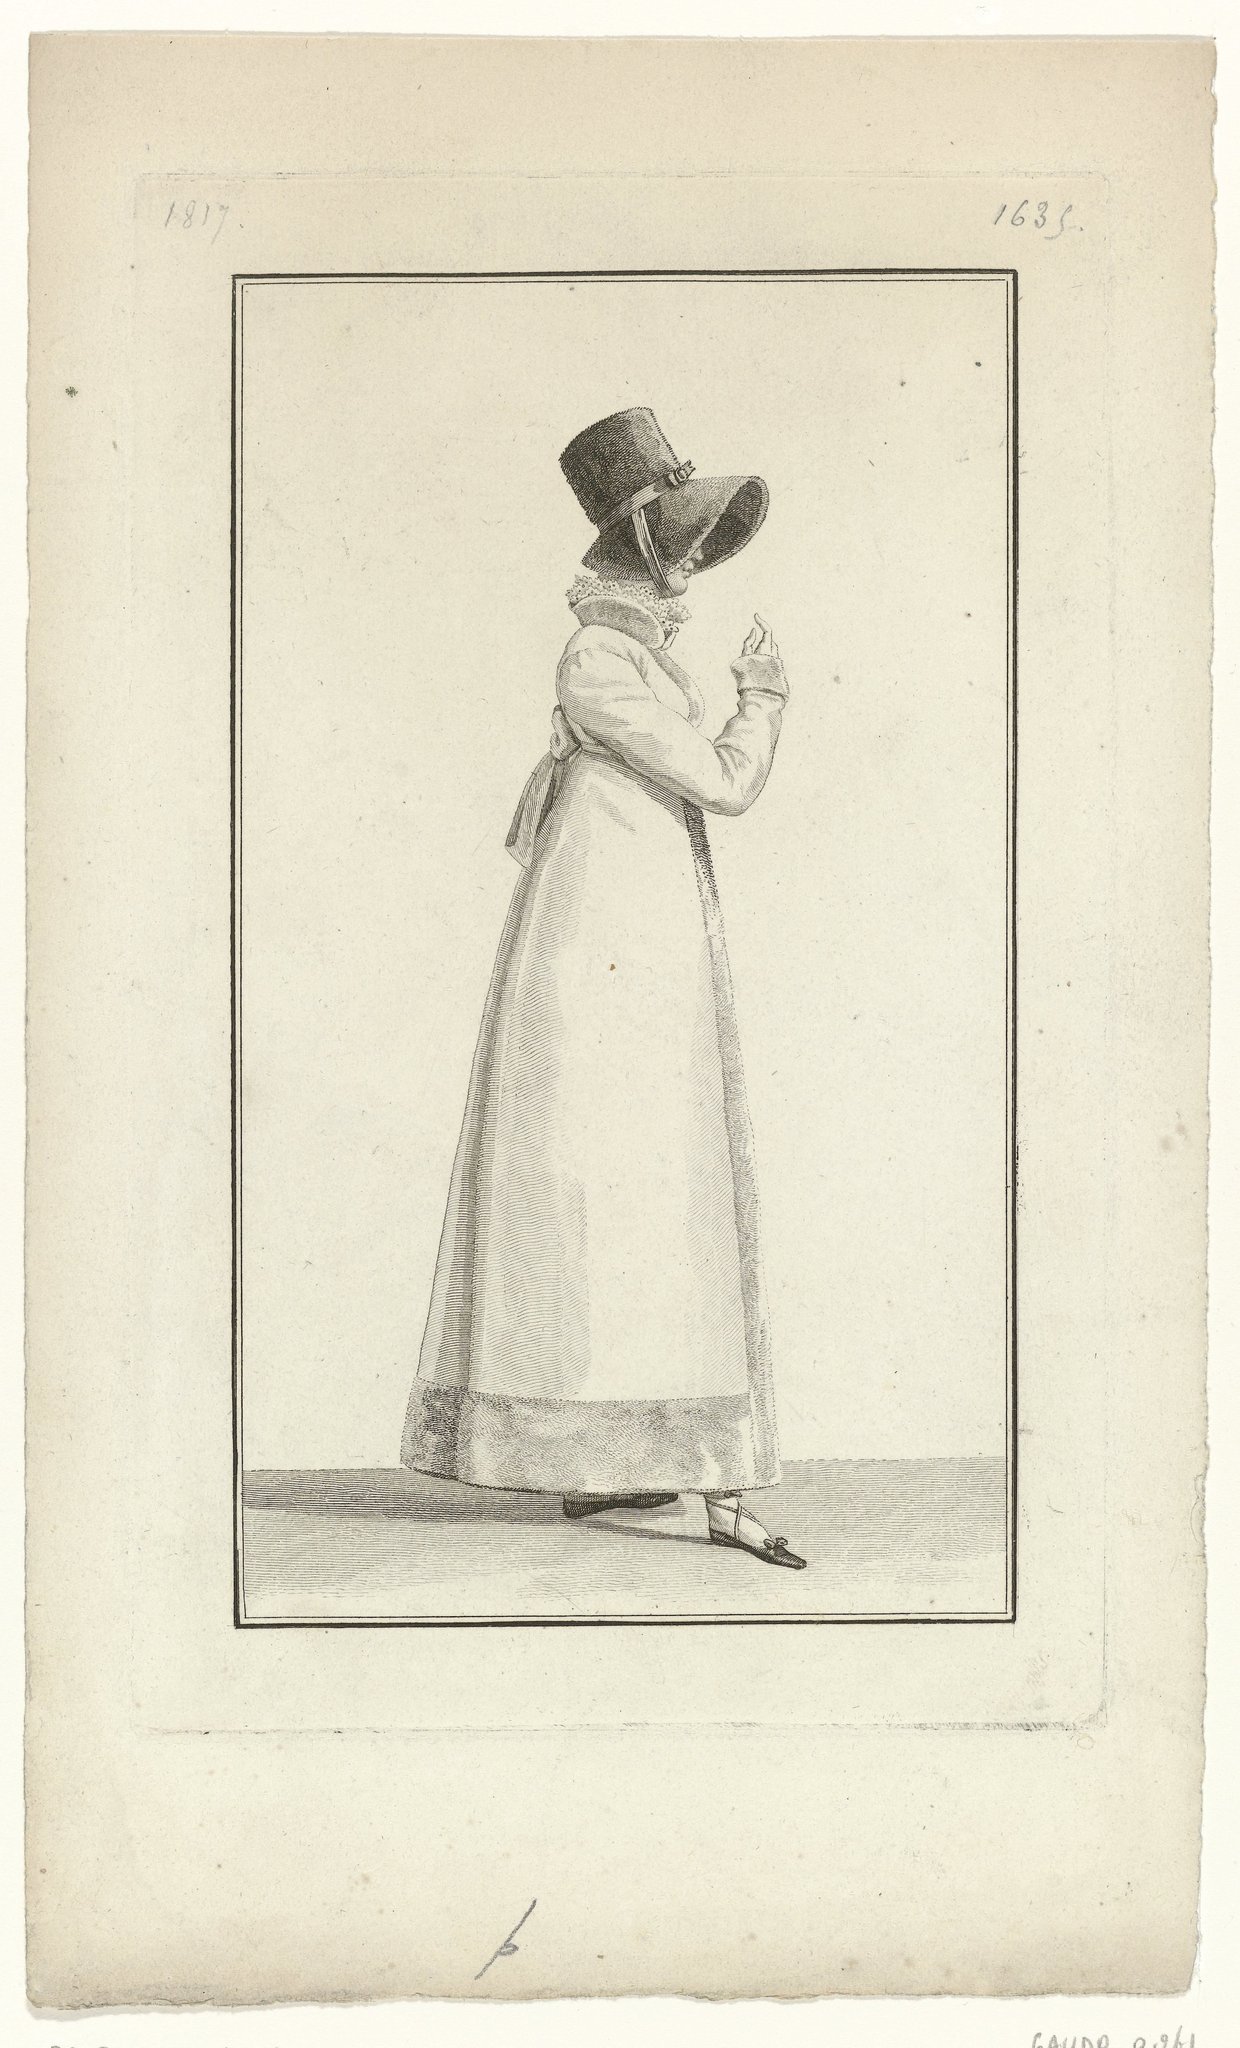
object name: fashion print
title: Journal des Dames et des Modes, Costume Parisien, 20 mars 1817 (1635)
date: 1817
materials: paper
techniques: engraving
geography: paris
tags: fashion plates, head-gear: hat (+ women's clothes), shoes, sandals (+ women's clothes), dress, gown (+ women's clothes), neck-gear ~ clothing (+ women's clothes)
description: Luifelhoed van 'castor'. Japon van merinowol afgezet met pluche. platte schoenen met gekruiste banden en strikken. Proefdruk van een prent uit het modetijdschrift Journal des Dames et des Modes, uitgegeven door Pierre de la Mésangère, Parijs, 1797-1839.